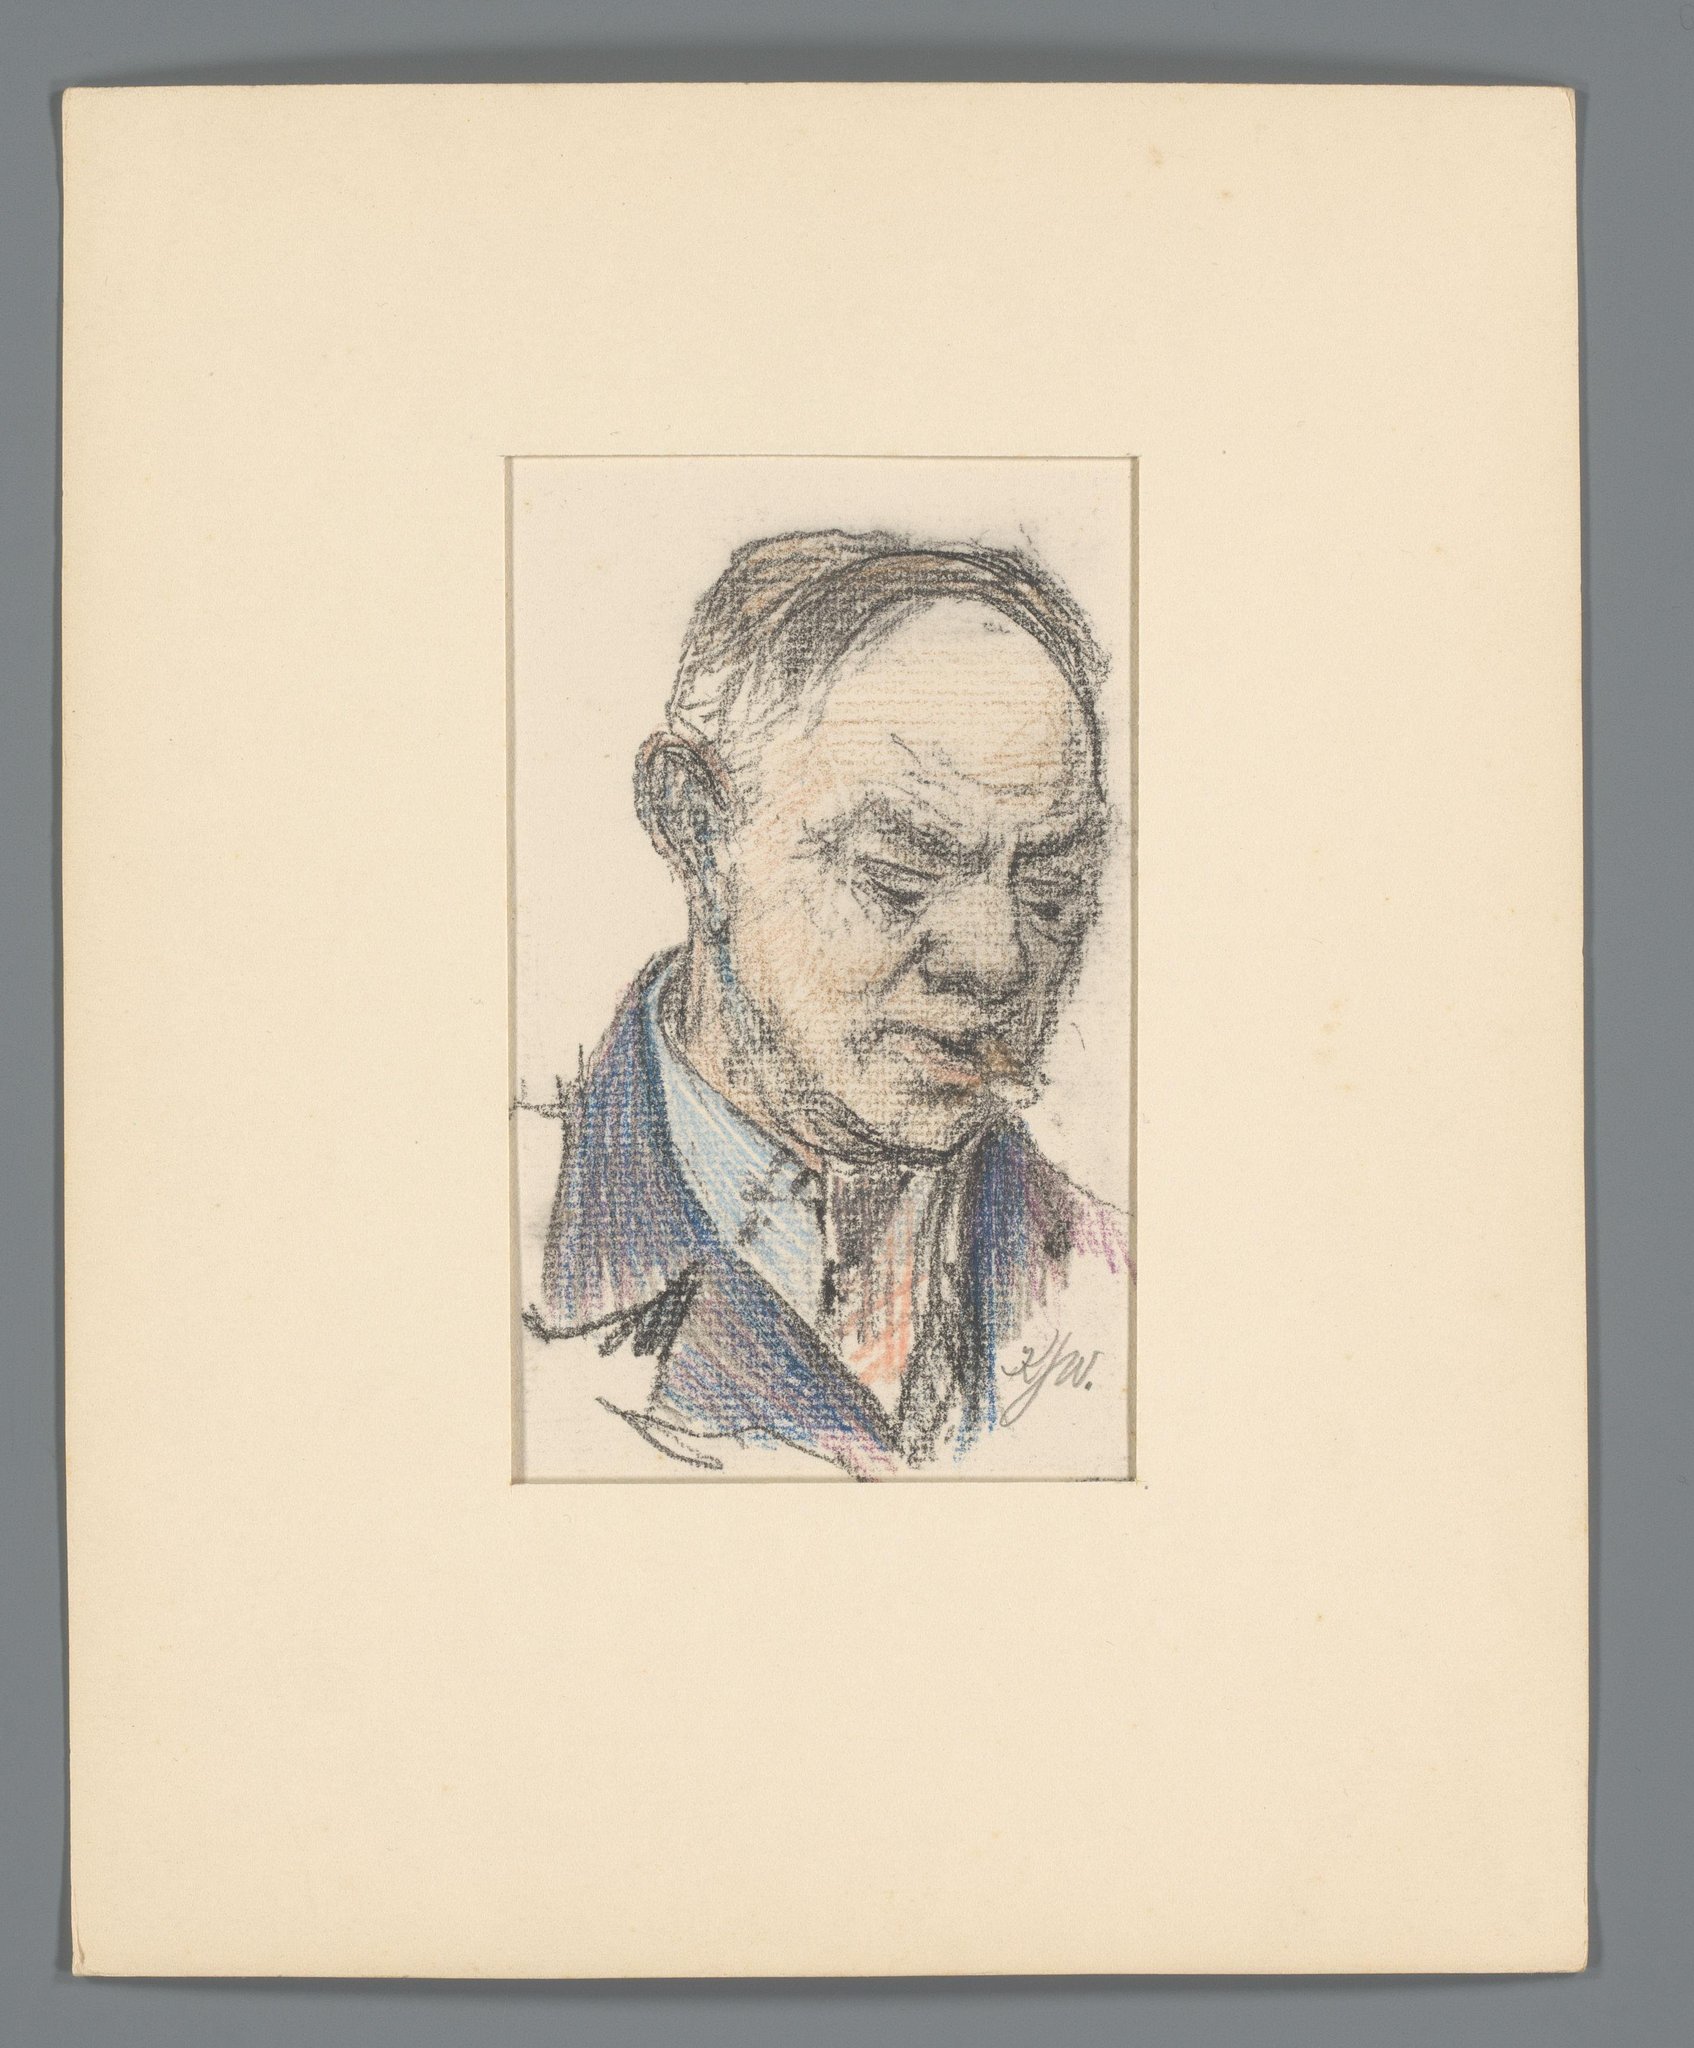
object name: drawing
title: Portret van een onbekende man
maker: Anonymous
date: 1920-1986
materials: chalk, paper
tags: historical persons not known by name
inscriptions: signature: ‘KJW.’